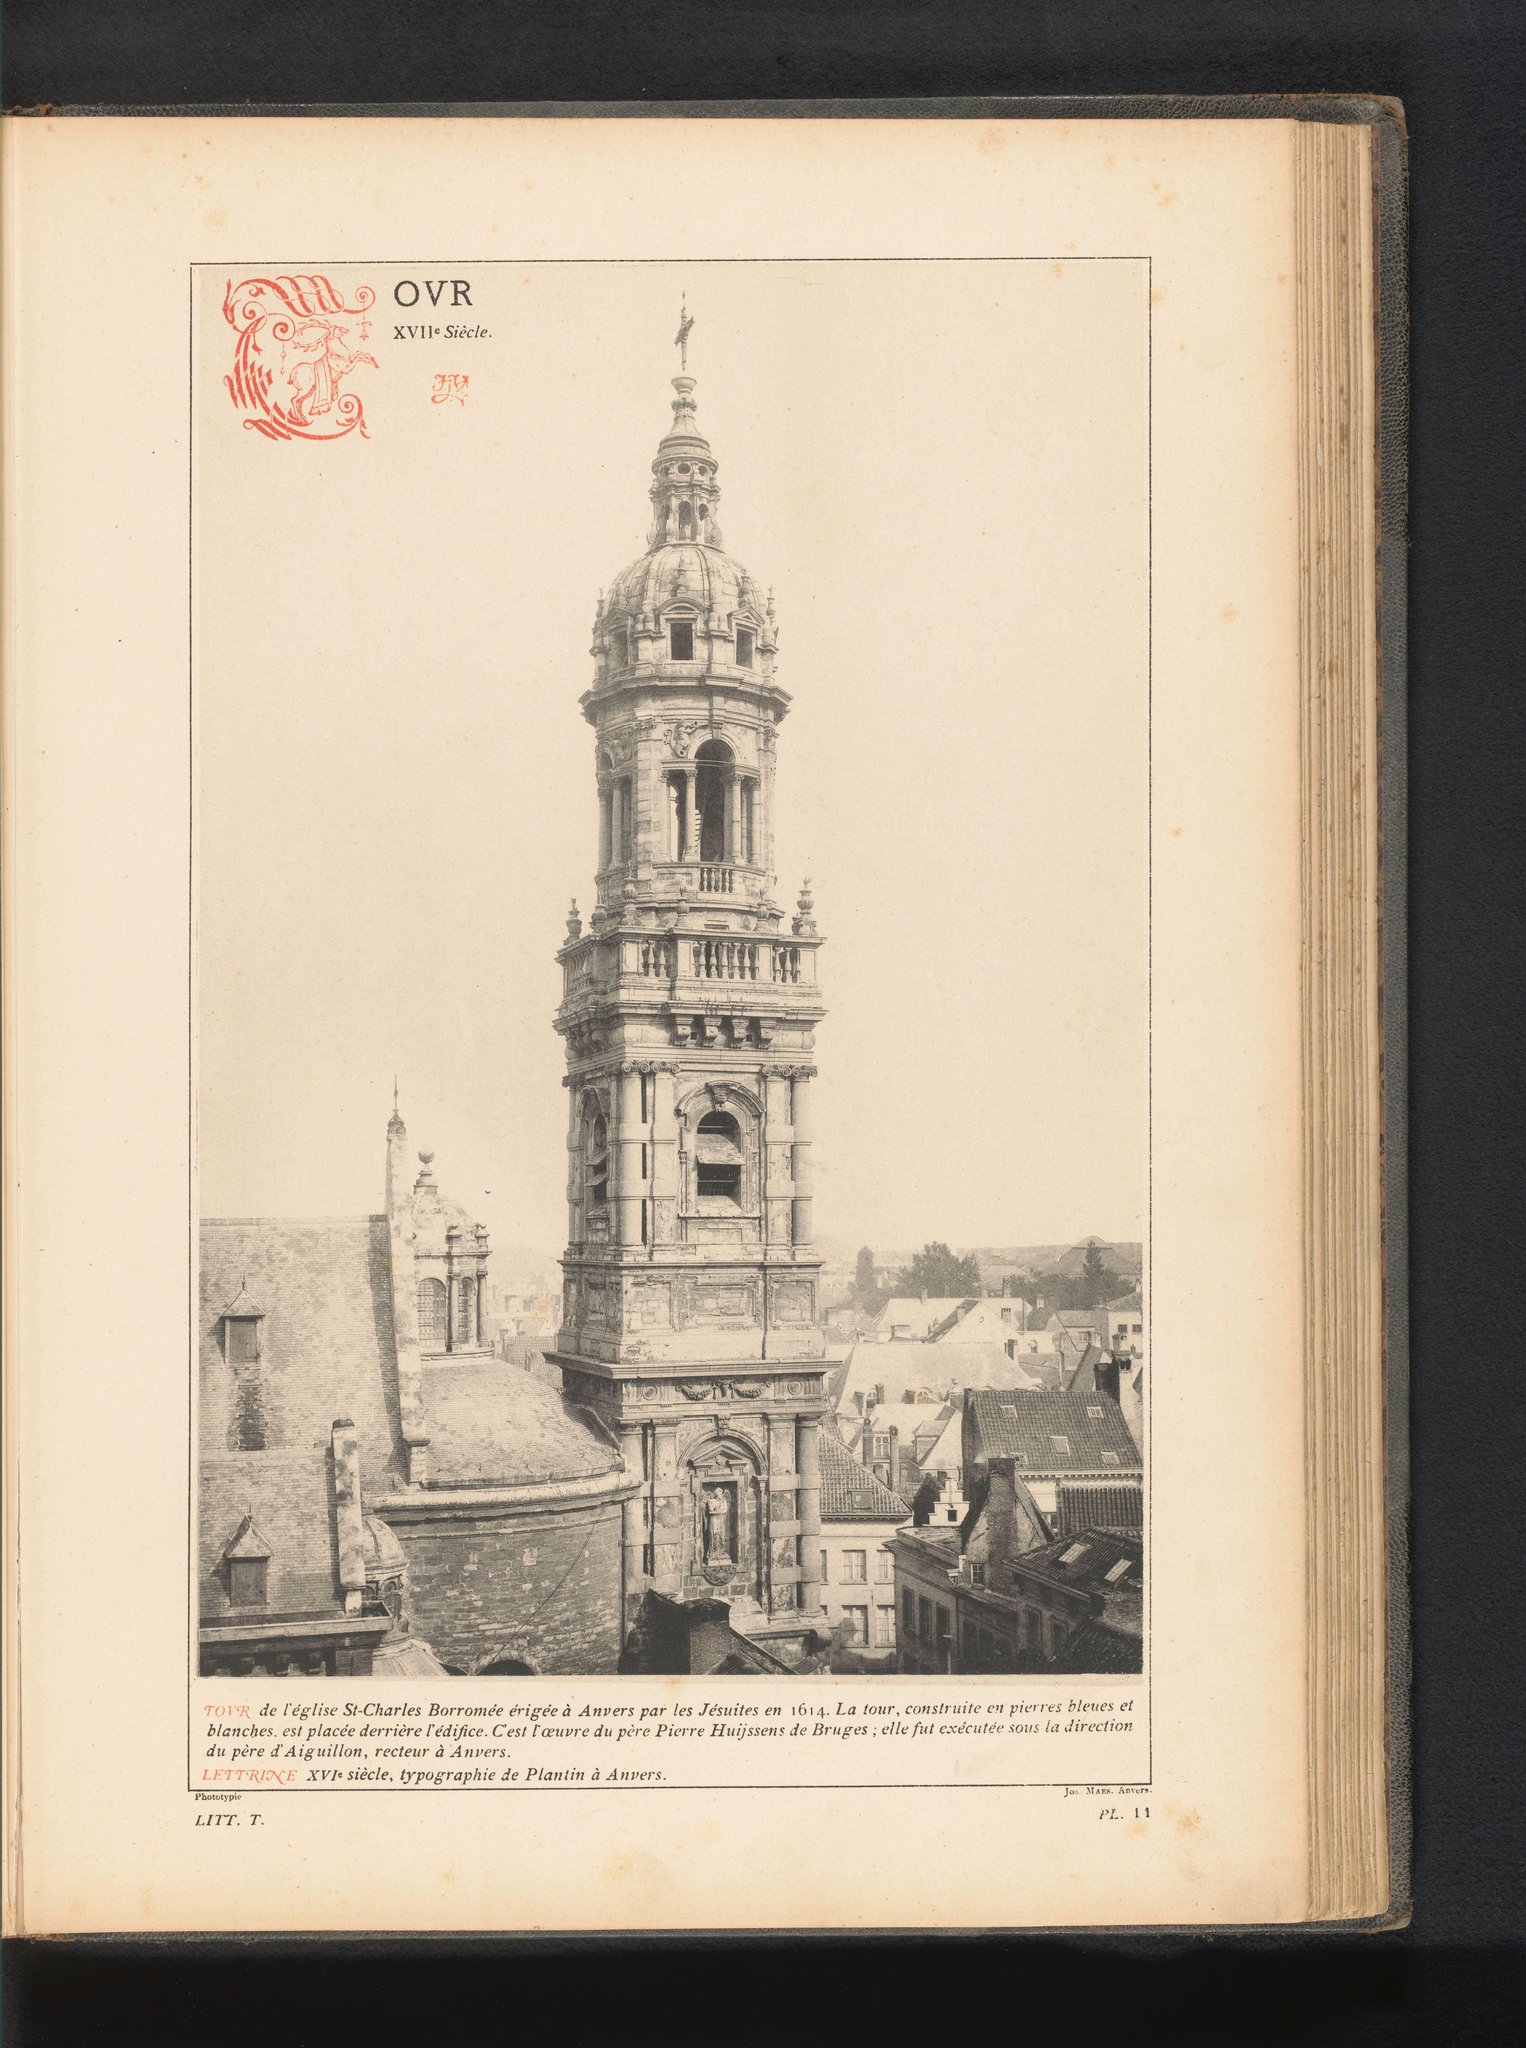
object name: page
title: Sint-Carolus Borromeuskerk te Antwerpen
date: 1876-1881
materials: paper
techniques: photograph, photolithography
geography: antwerp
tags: parts of church exterior and annexes: tower, antwerp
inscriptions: monogram: ‘JJvY’, inscription: ‘TOUR de l'église (...)’, inscription: ‘LITT. T. - PL. 11.’